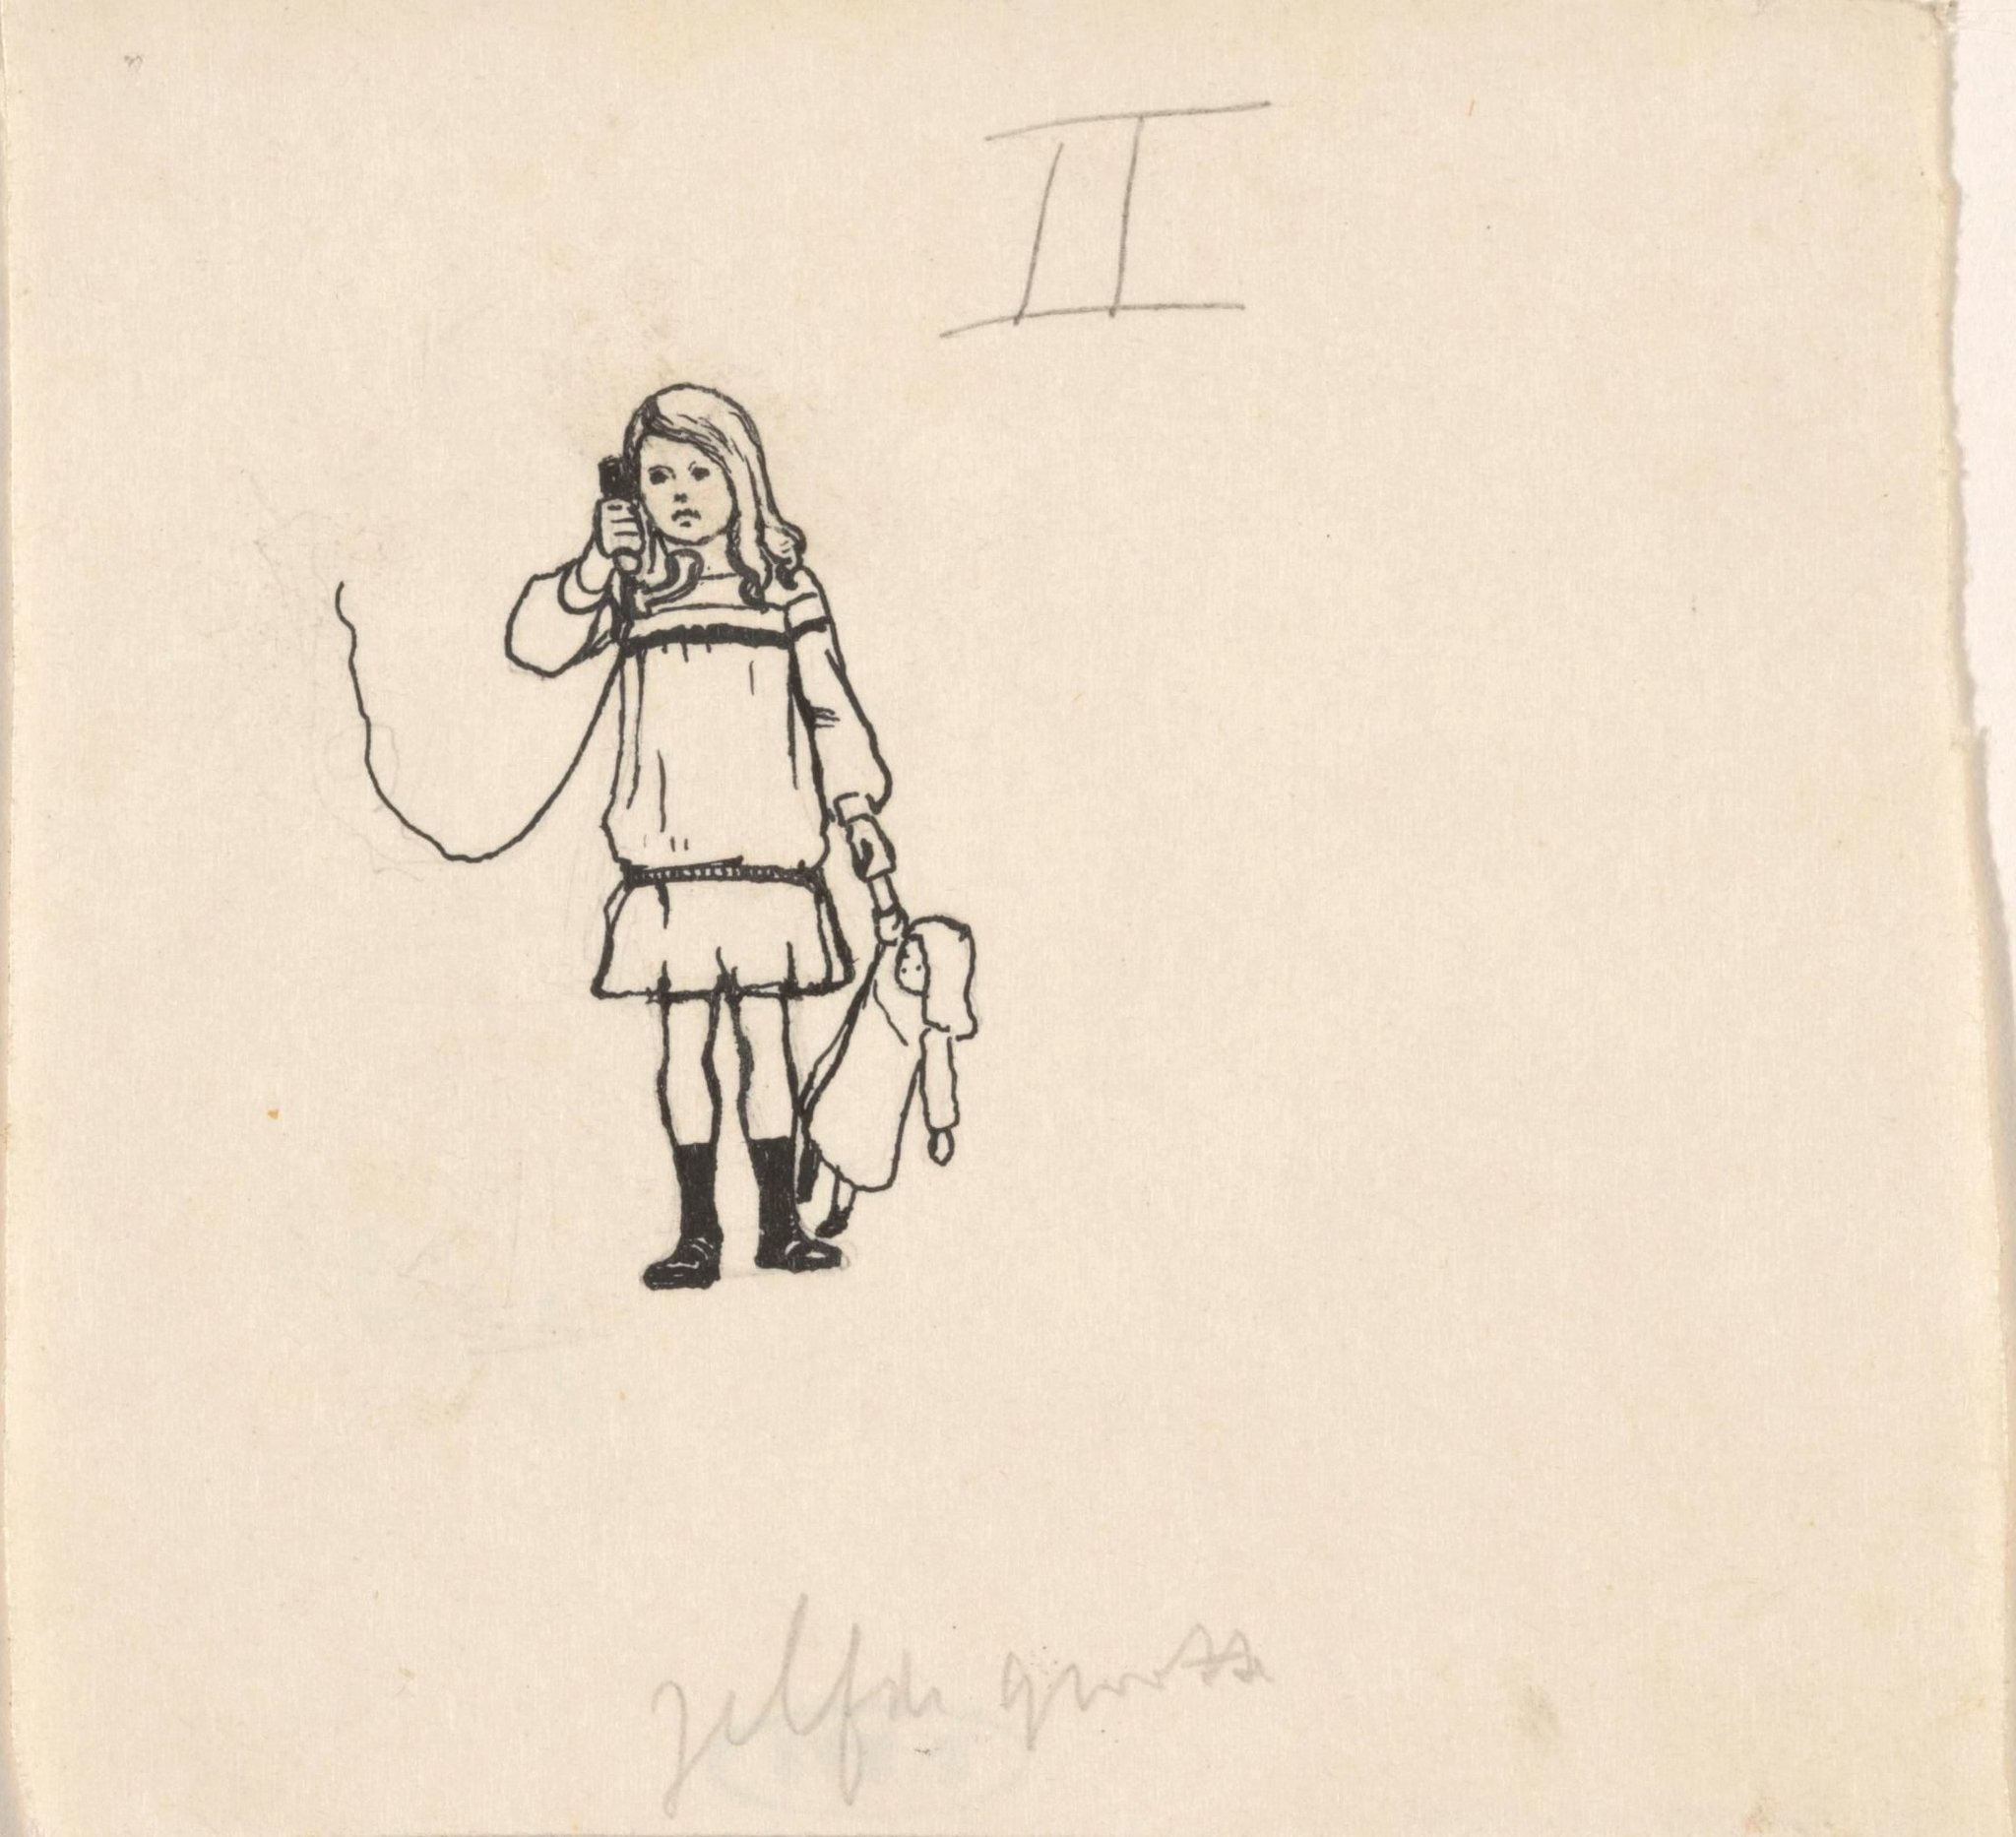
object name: drawing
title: Telefonerend meisje met pop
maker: gijsbertus johannes van overbeek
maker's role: draughtsman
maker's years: 1882-1947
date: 1892-1947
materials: ink, paper, pencil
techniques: pen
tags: telephone, girl (child between toddler and youth), (playing with) dolls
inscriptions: number: ‘II’, collector's mark: Lugt 2228, :